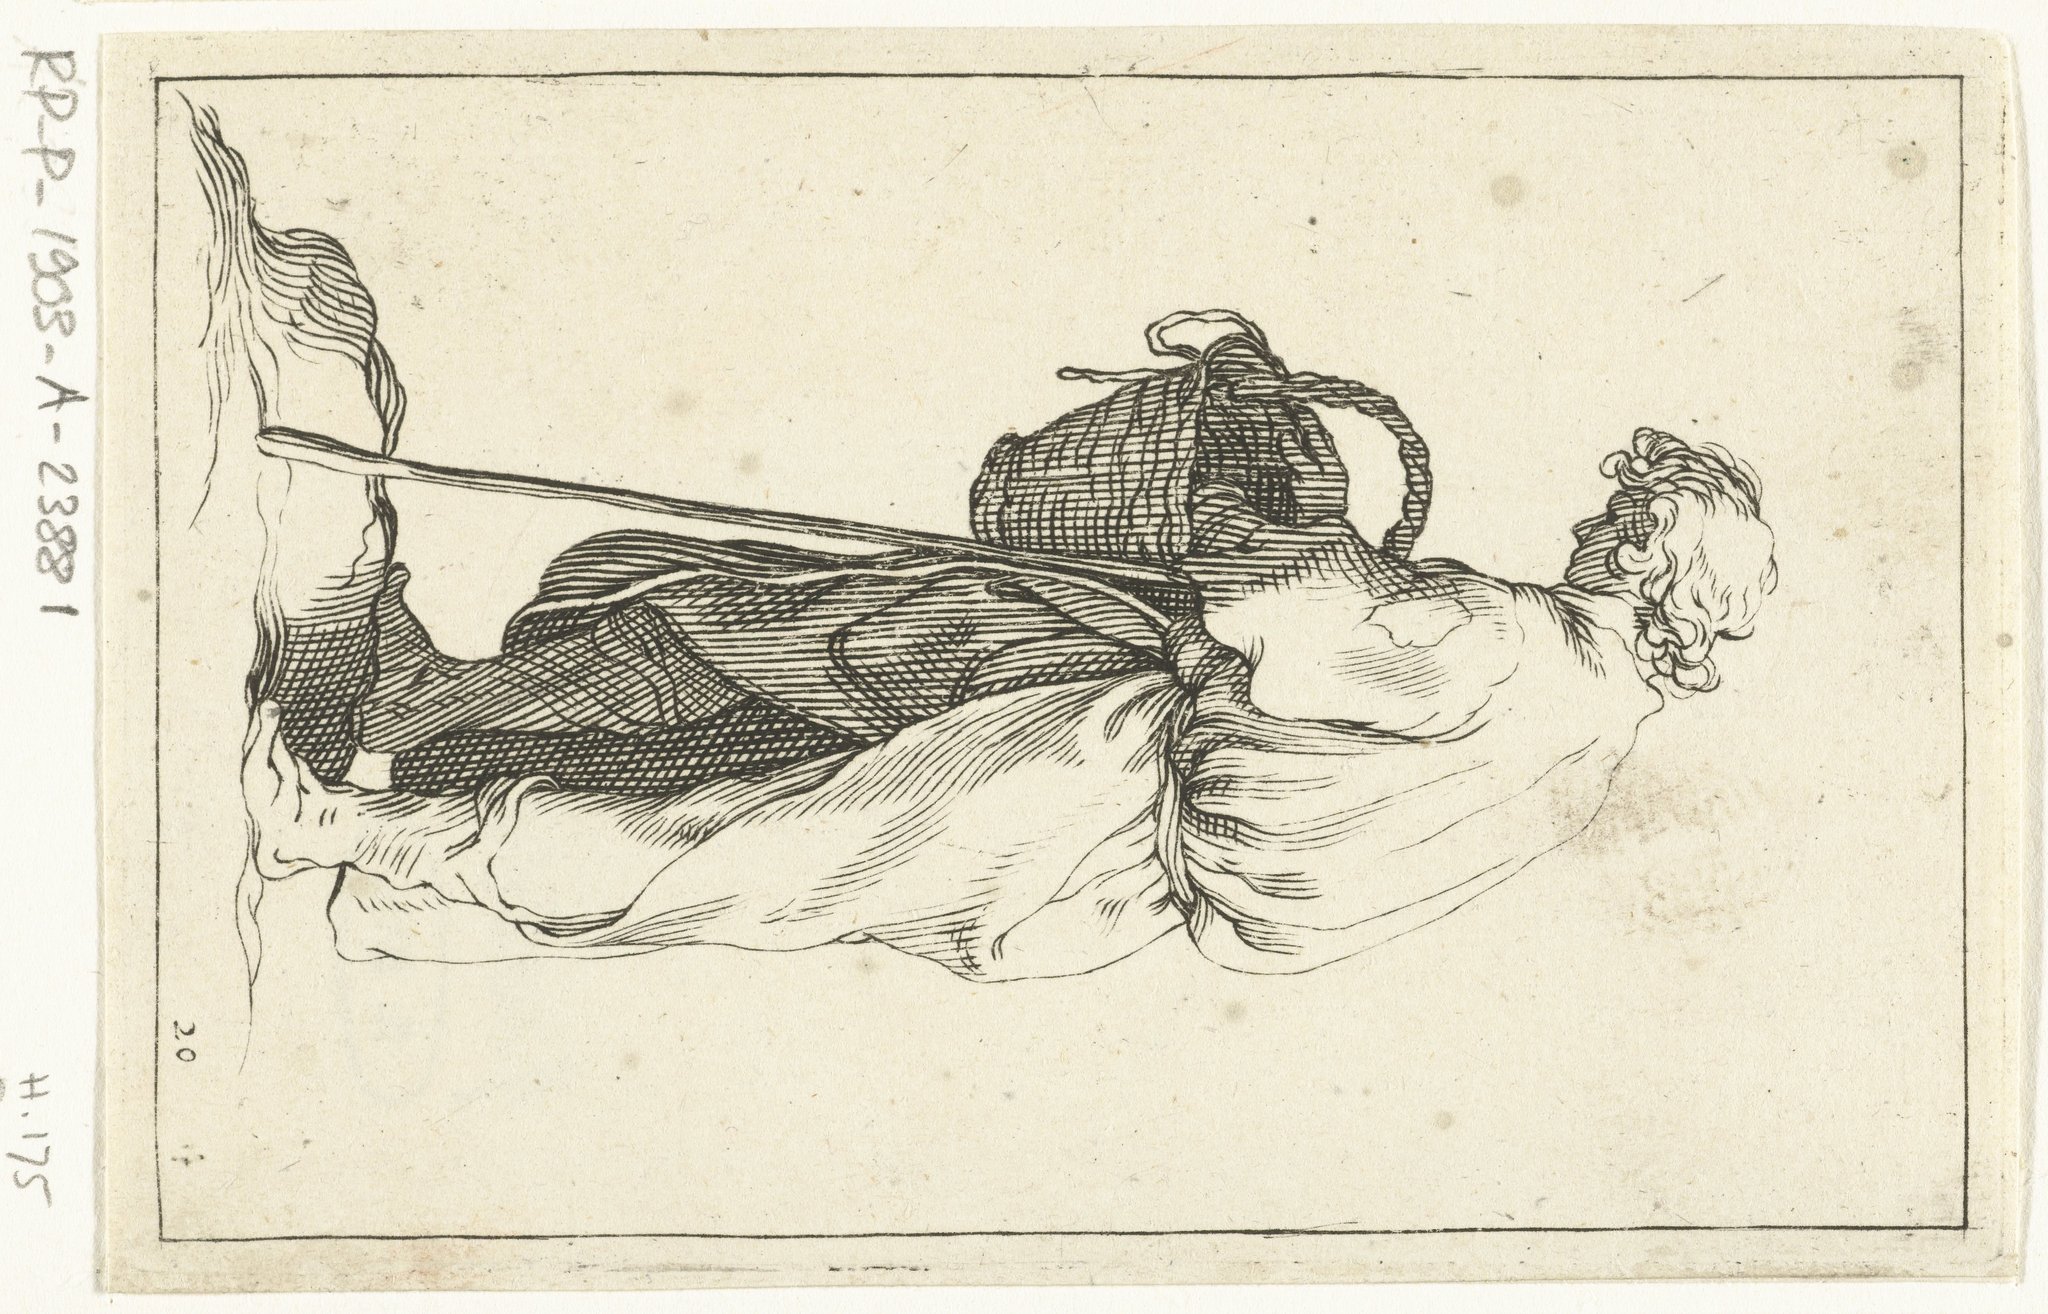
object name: print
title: De kleine figuren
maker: frederick bloemaert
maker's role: print maker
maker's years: 1614-1669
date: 1635-1669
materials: paper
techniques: engraving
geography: utrecht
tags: farmers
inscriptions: collector's mark: Lugt 2228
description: Een jonge man met stokzoekt iets in zijn mand.